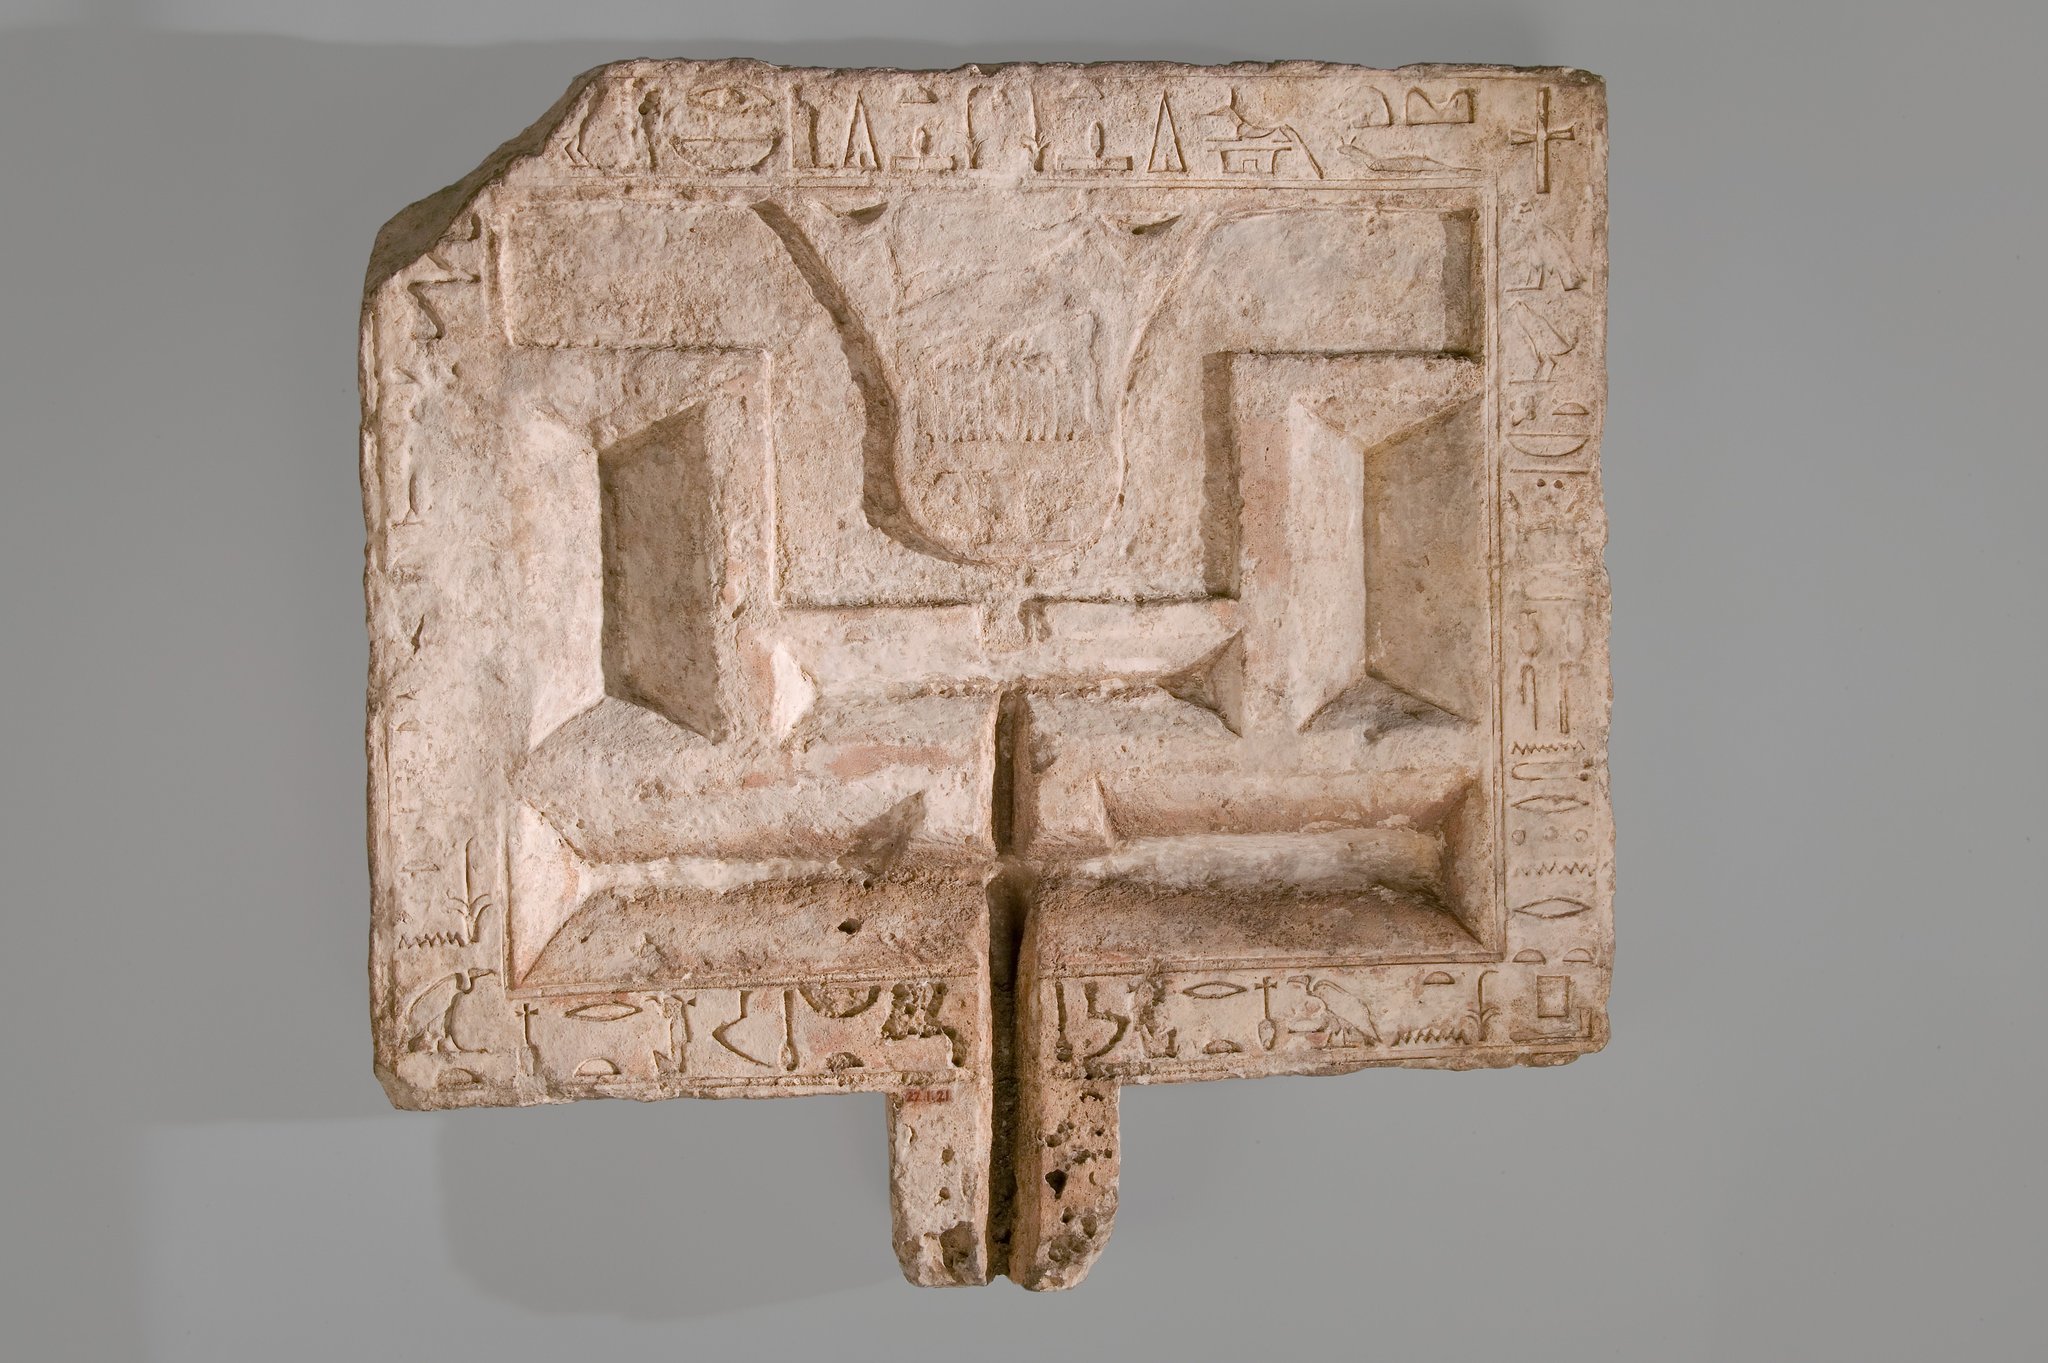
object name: offering table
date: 1981-1802 BCE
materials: limestone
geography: egypt